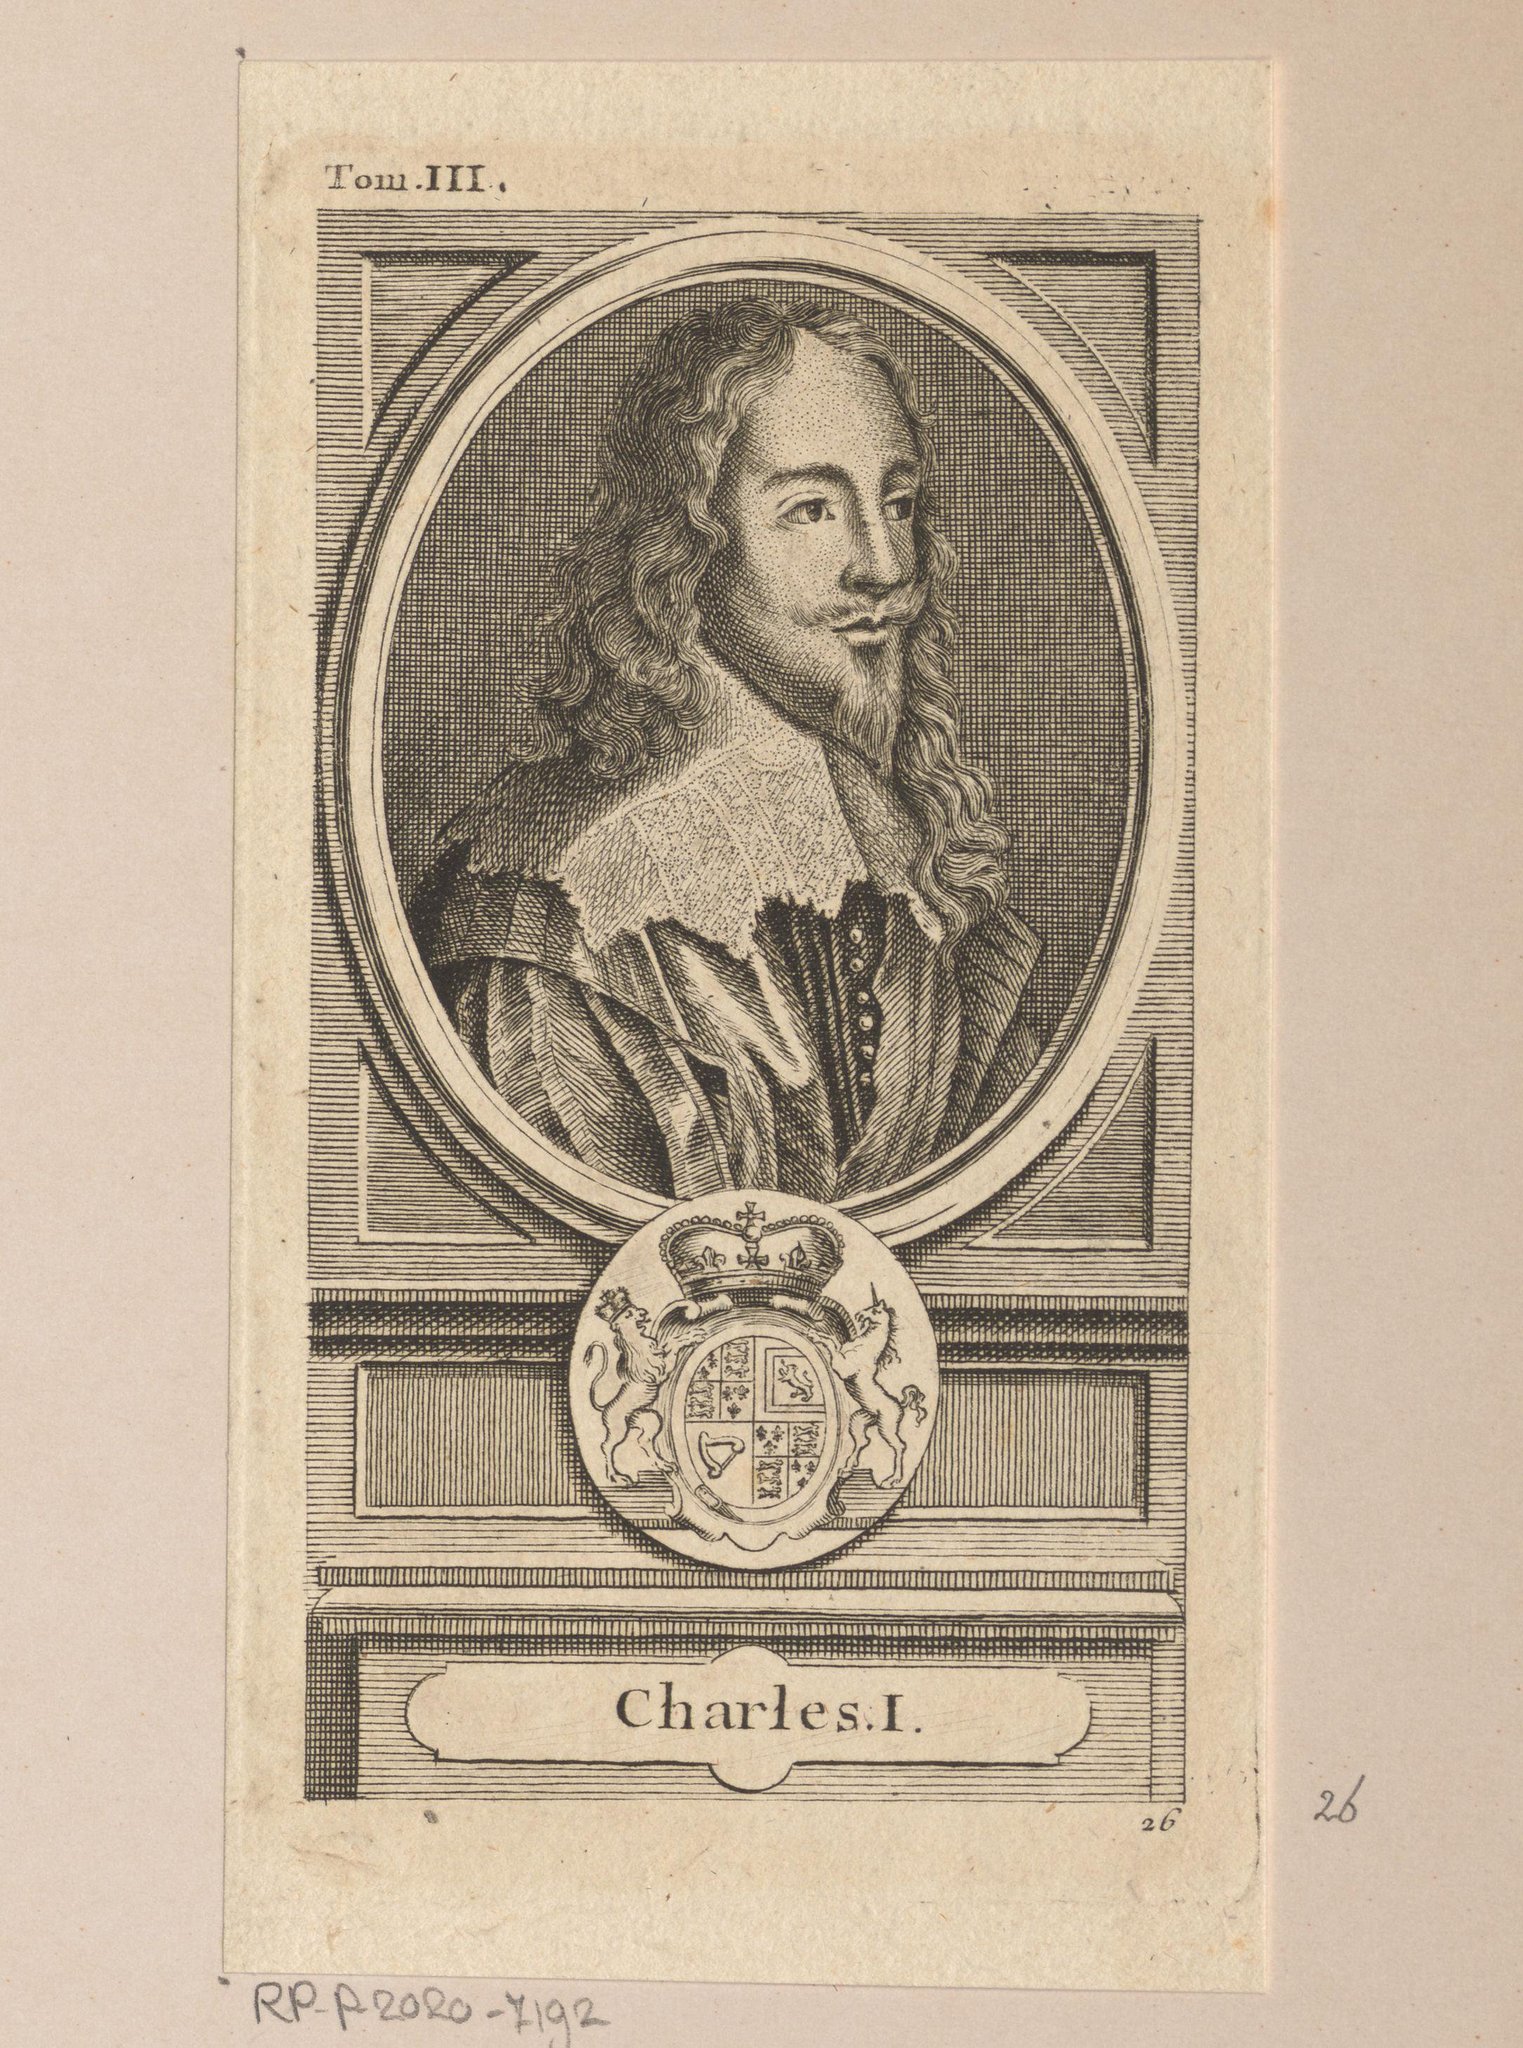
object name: print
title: Portret van Karel I, koning van Engeland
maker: Anonymous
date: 1625-1699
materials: paper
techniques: engraving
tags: karel i (koning van engeland), historical persons, king, armorial bearing, heraldry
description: Onder het portret zijn wapenschild. Linksboven genummerd: Tom. III. Rechtsonder genummerd: 26.